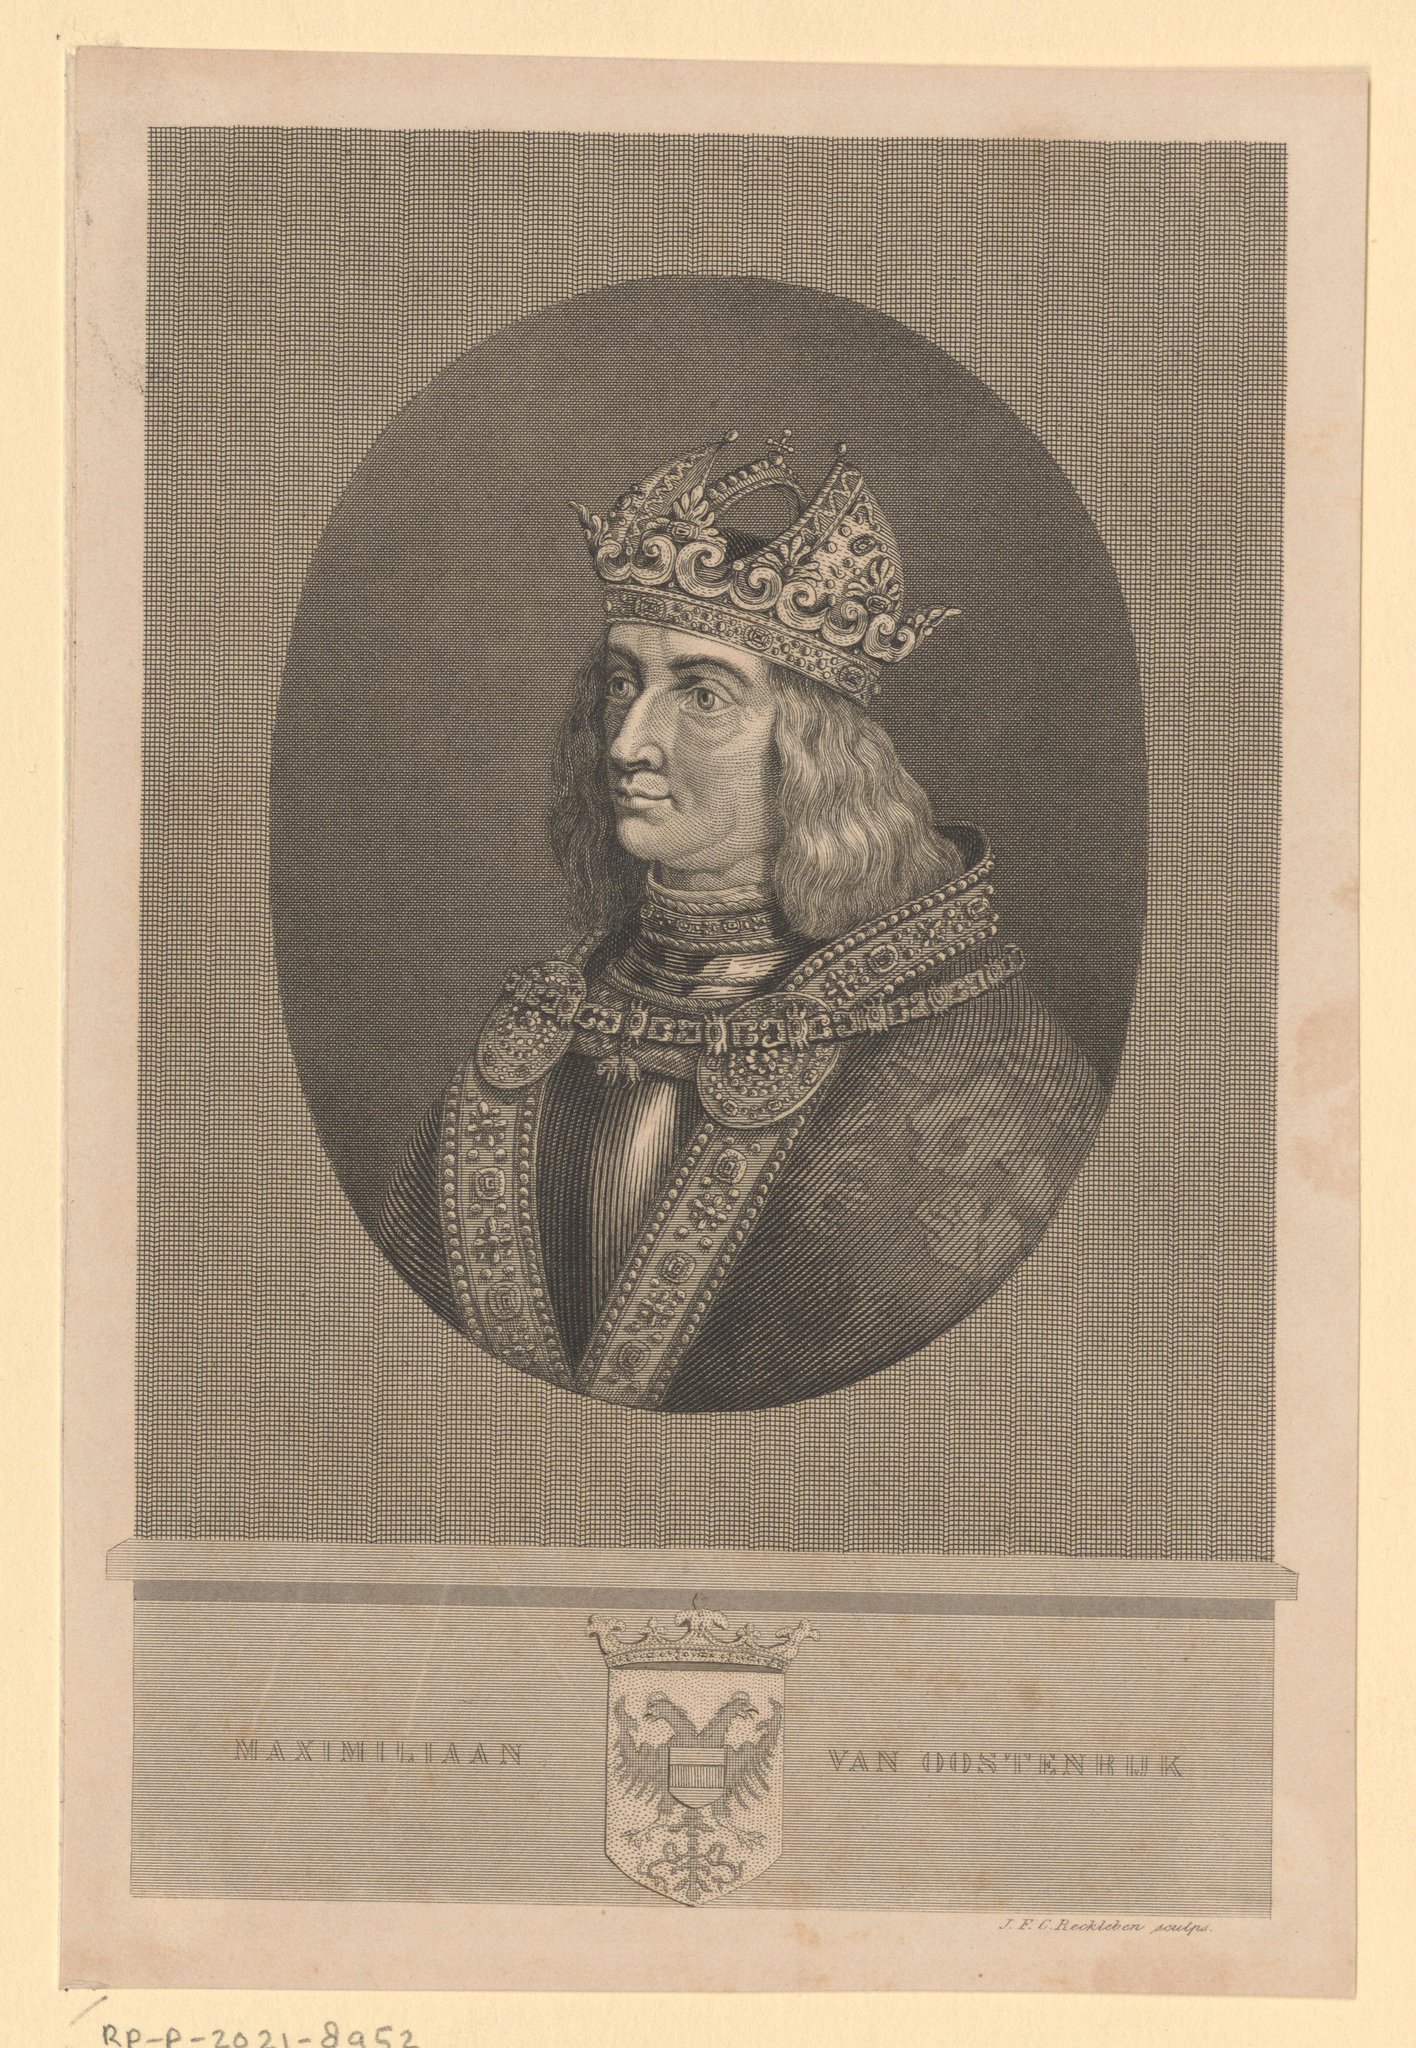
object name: print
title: Portret van keizer Maximiliaan I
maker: jan frederik christiaan reckleben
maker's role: print maker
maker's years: 1819-1879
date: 1849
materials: paper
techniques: engraving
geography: amsterdam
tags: maximilian i (holy roman emperor), crown (symbol of sovereignty), historical persons, emperor, knighthood order of the golden fleece - insignia of a knighthood order, e.g.: badge, chain (with name of order), armorial bearing, heraldry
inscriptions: number: ‘No. 546.’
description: Prent waarschijnlijk uit: Arend, Johannes Pieter. Algemeene geschiedenis des vaderlands van de vroegste tijden tot op heden. 5 dln. Amsterdam: J.F. Schleijer, 1849, dl. 2-3.